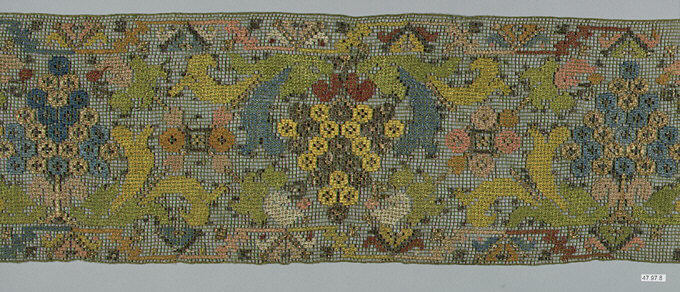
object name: band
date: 1624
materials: metal thread, silk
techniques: embroidery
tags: flowers